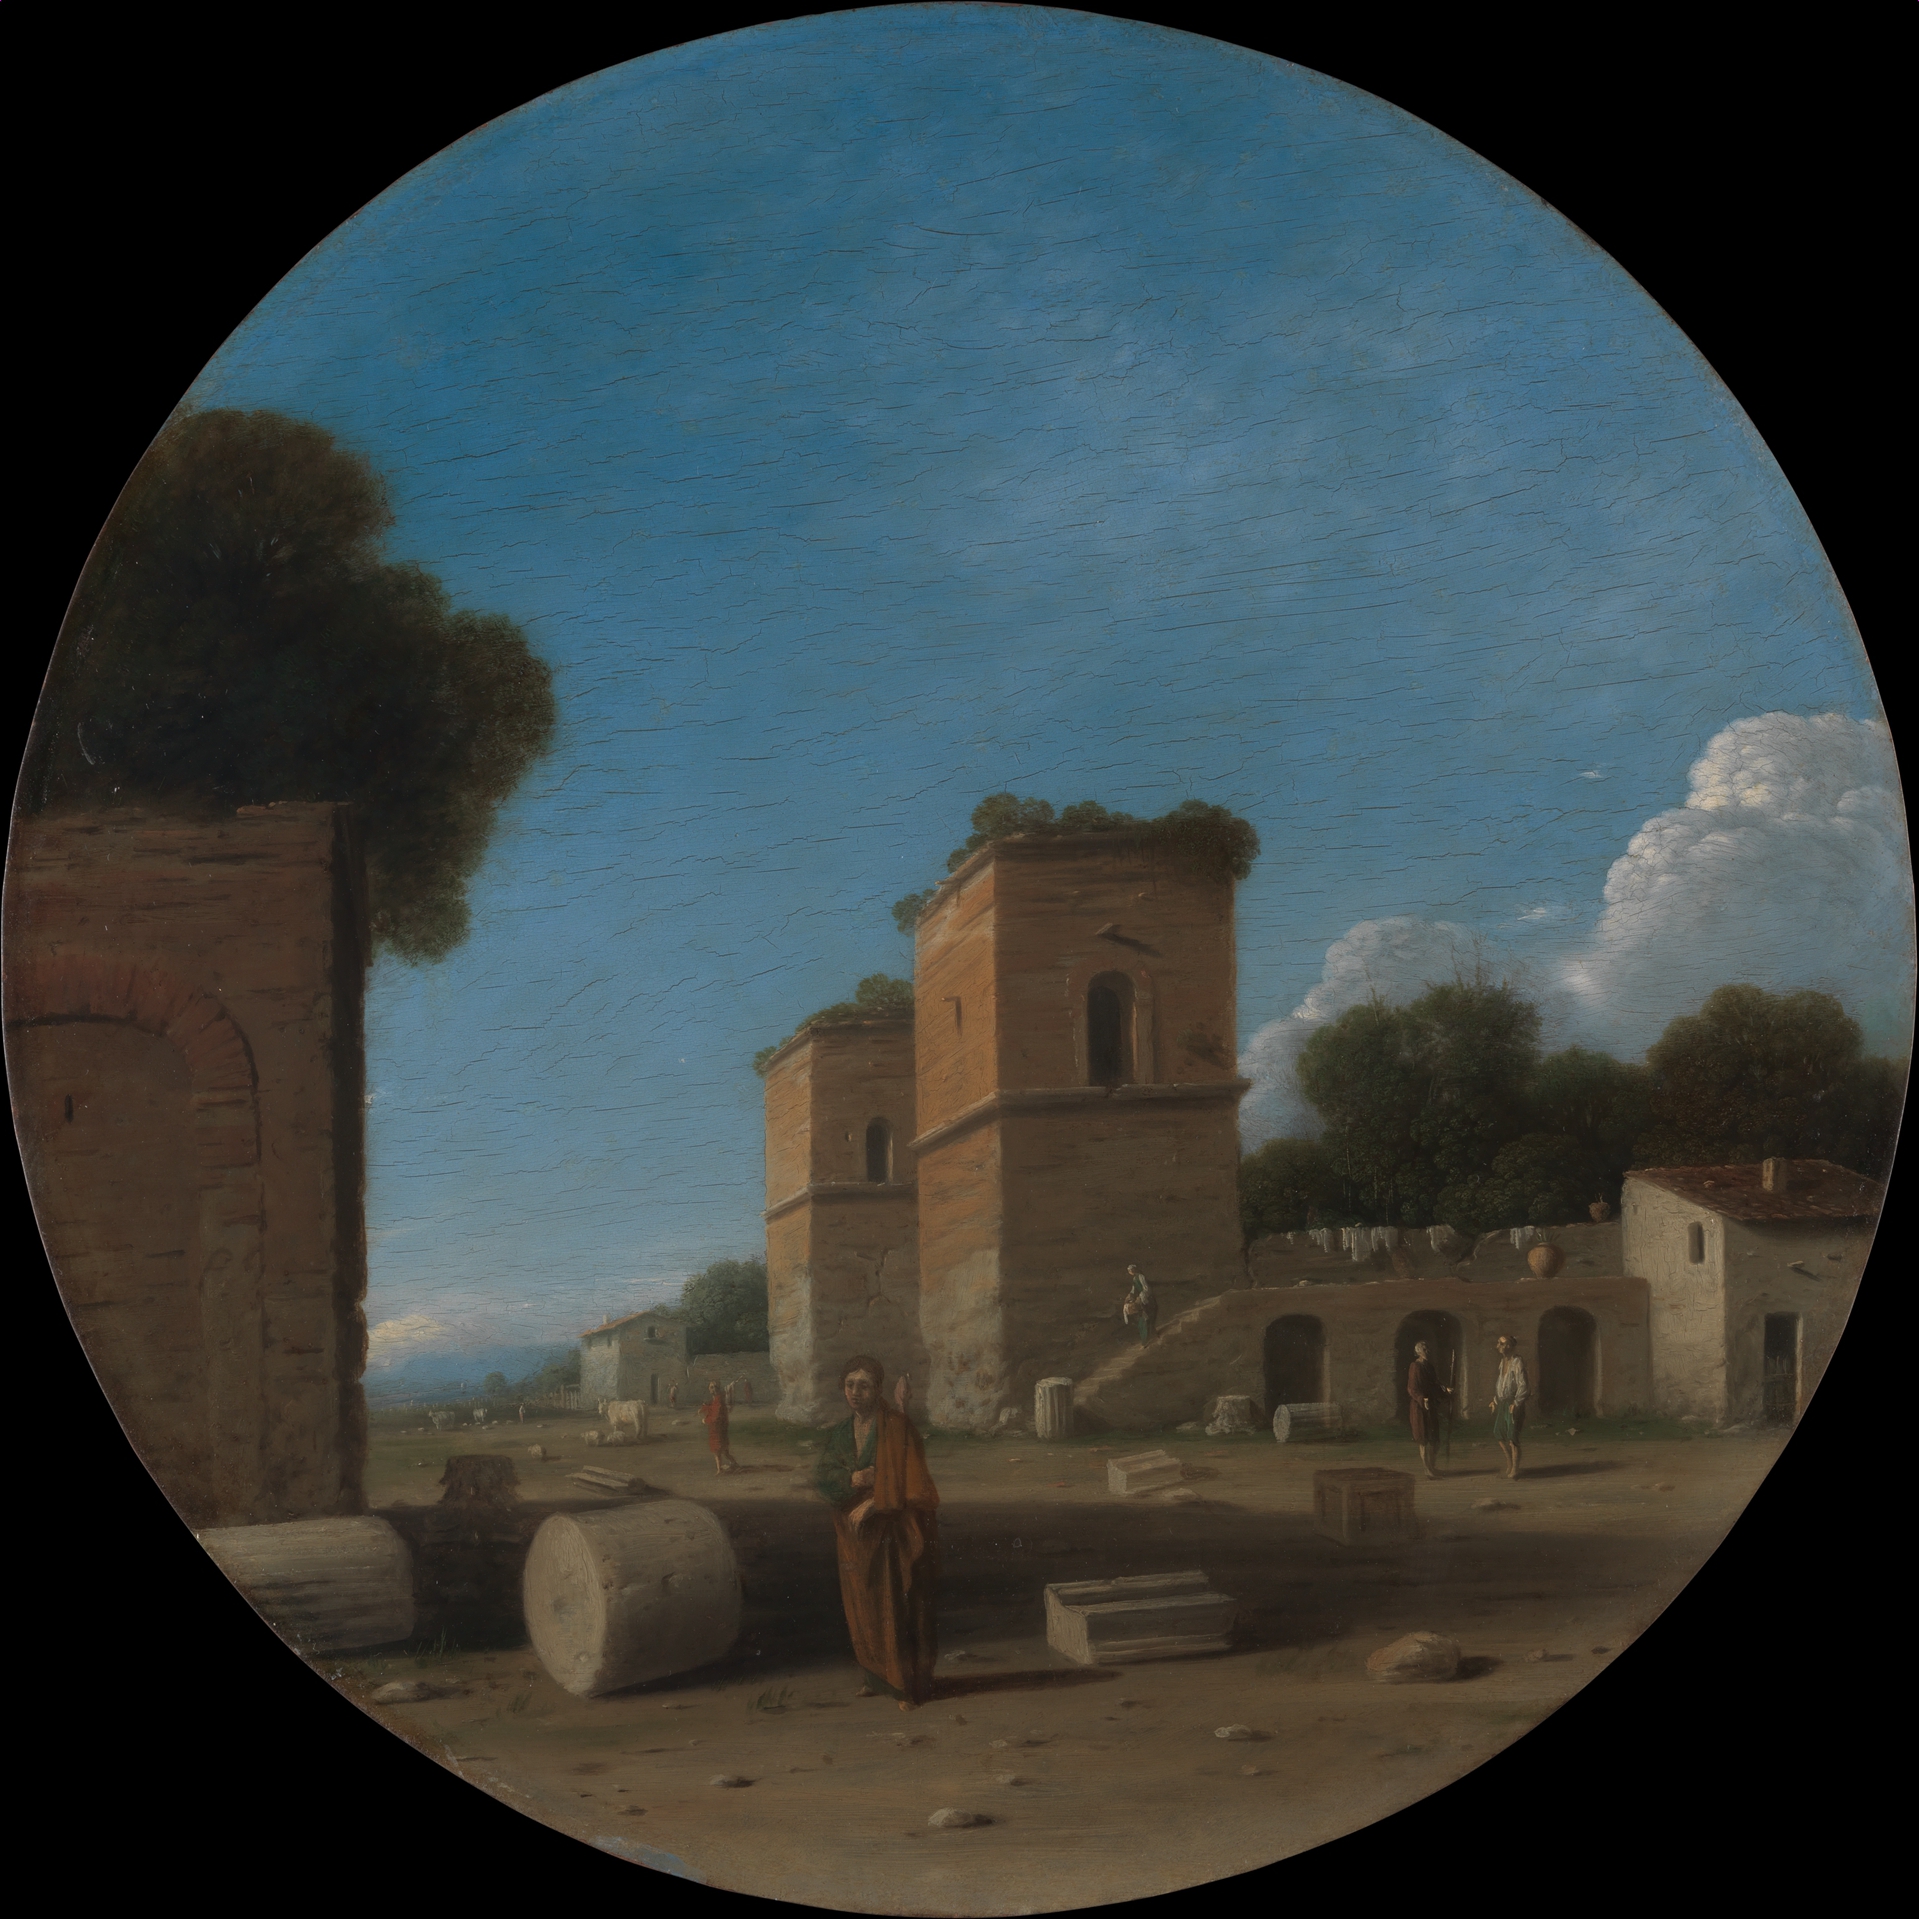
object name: painting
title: A Roman Landscape with Figures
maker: goffredo wals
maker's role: artist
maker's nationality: german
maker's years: 1590-1640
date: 1630-1639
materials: copper, oil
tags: ruins,landscapes,rome